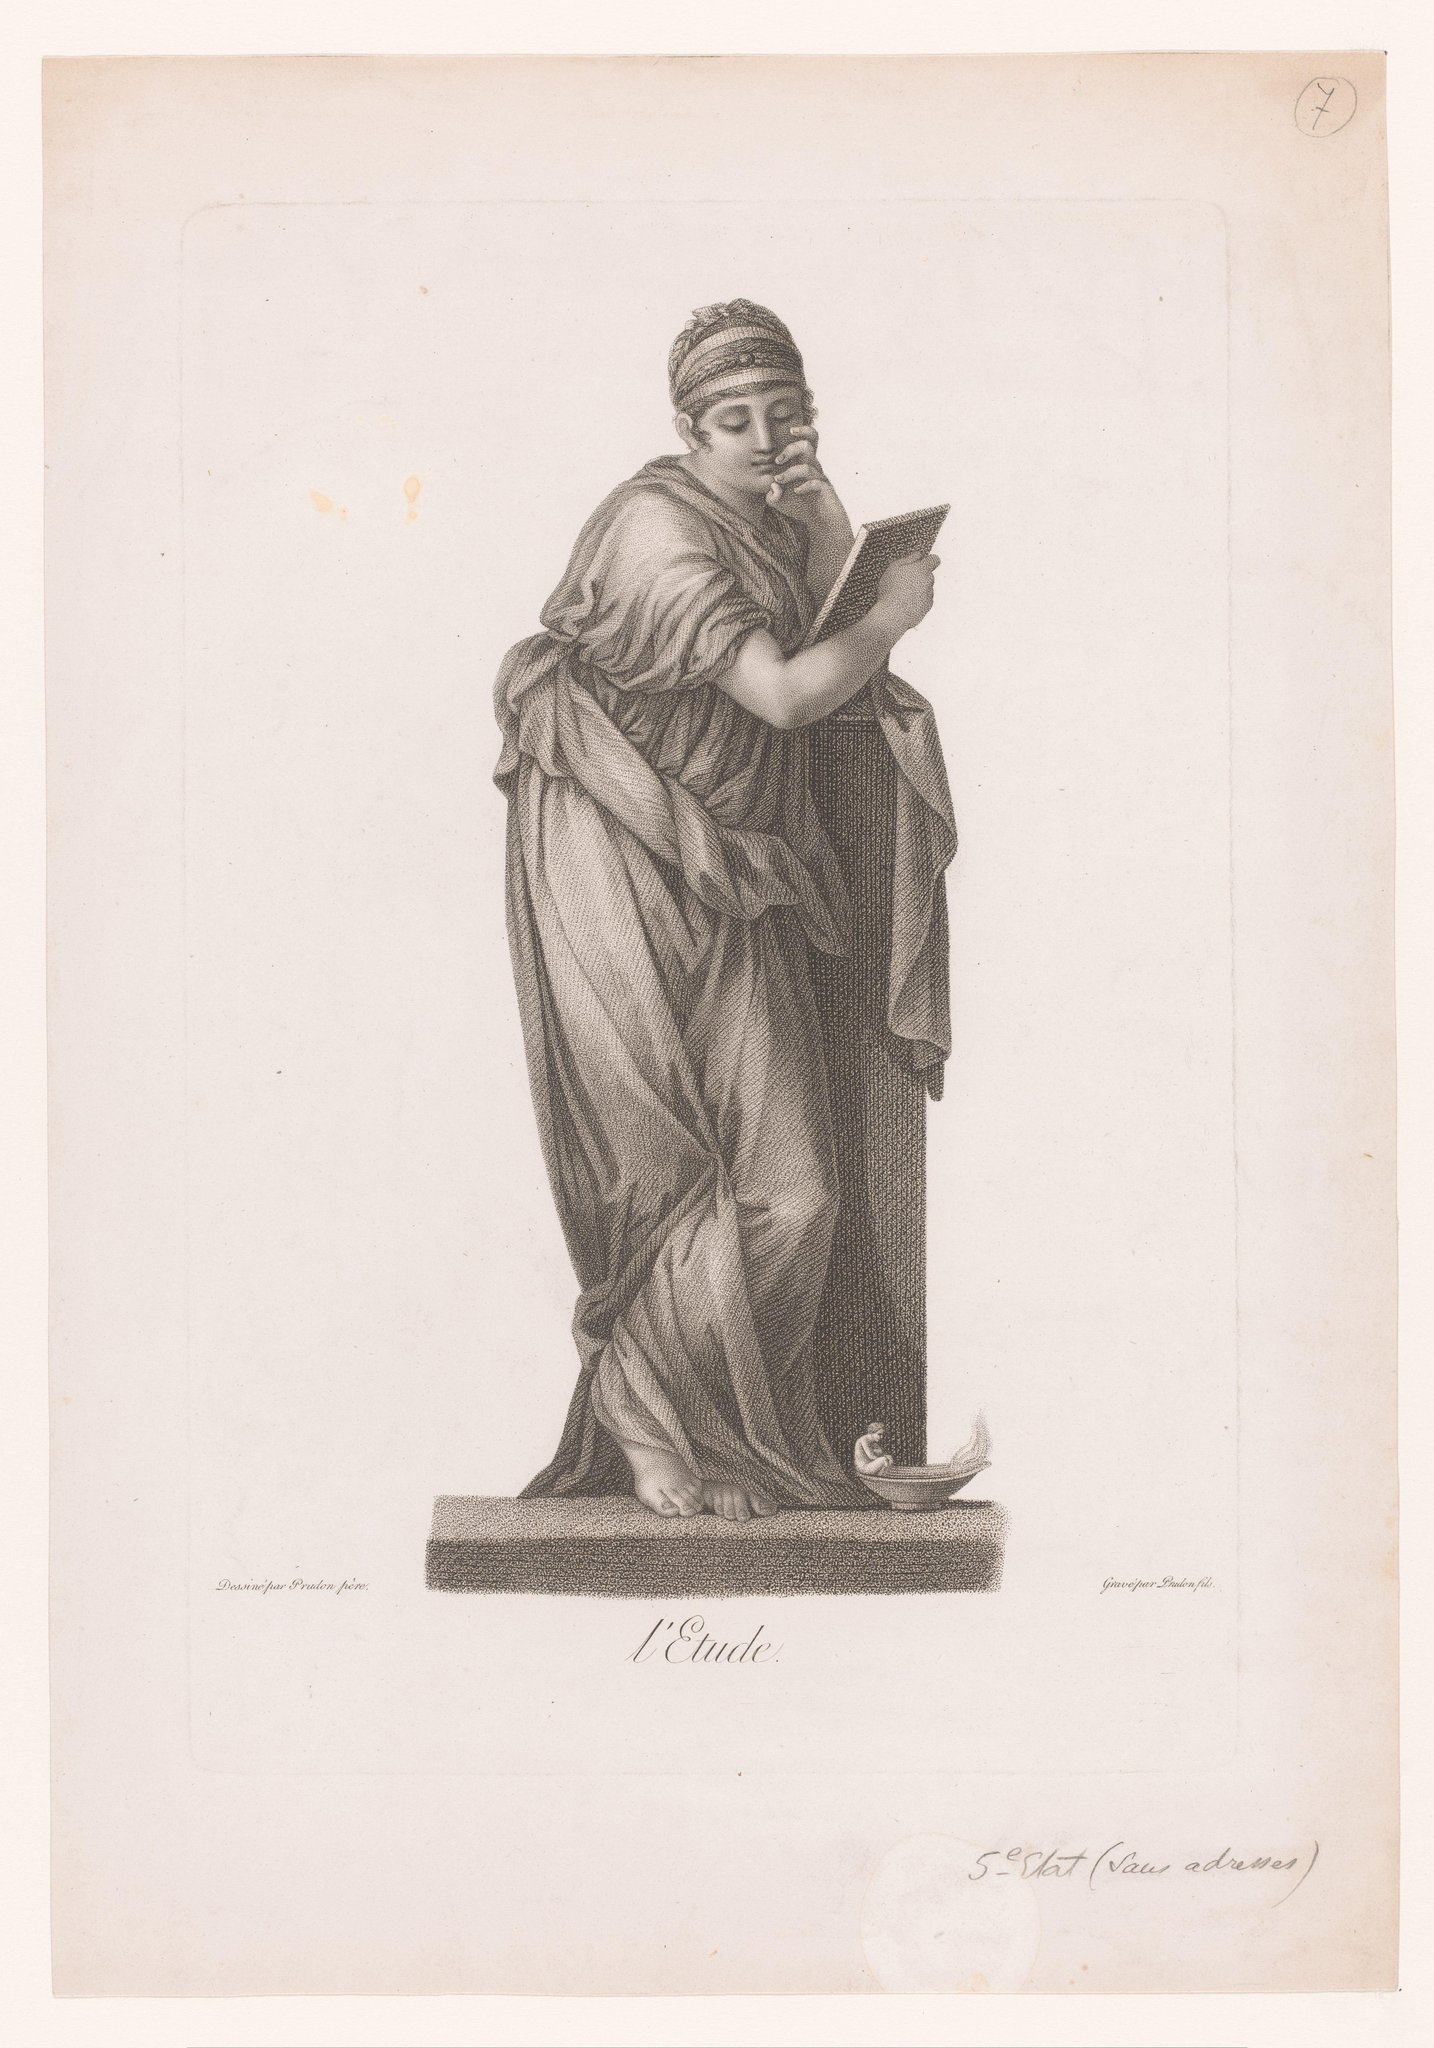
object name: print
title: Studie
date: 1810-1823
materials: paper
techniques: engraving, etching, roulette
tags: 49a1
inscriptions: collector's mark: Lugt 2228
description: Serie naar de figuren die als decoratie gebruikt zijn in het stadhuis, tijdens het huwelijk van Napoleon I Bonaparte en Marie Louise van Oostenrijk in 1810.